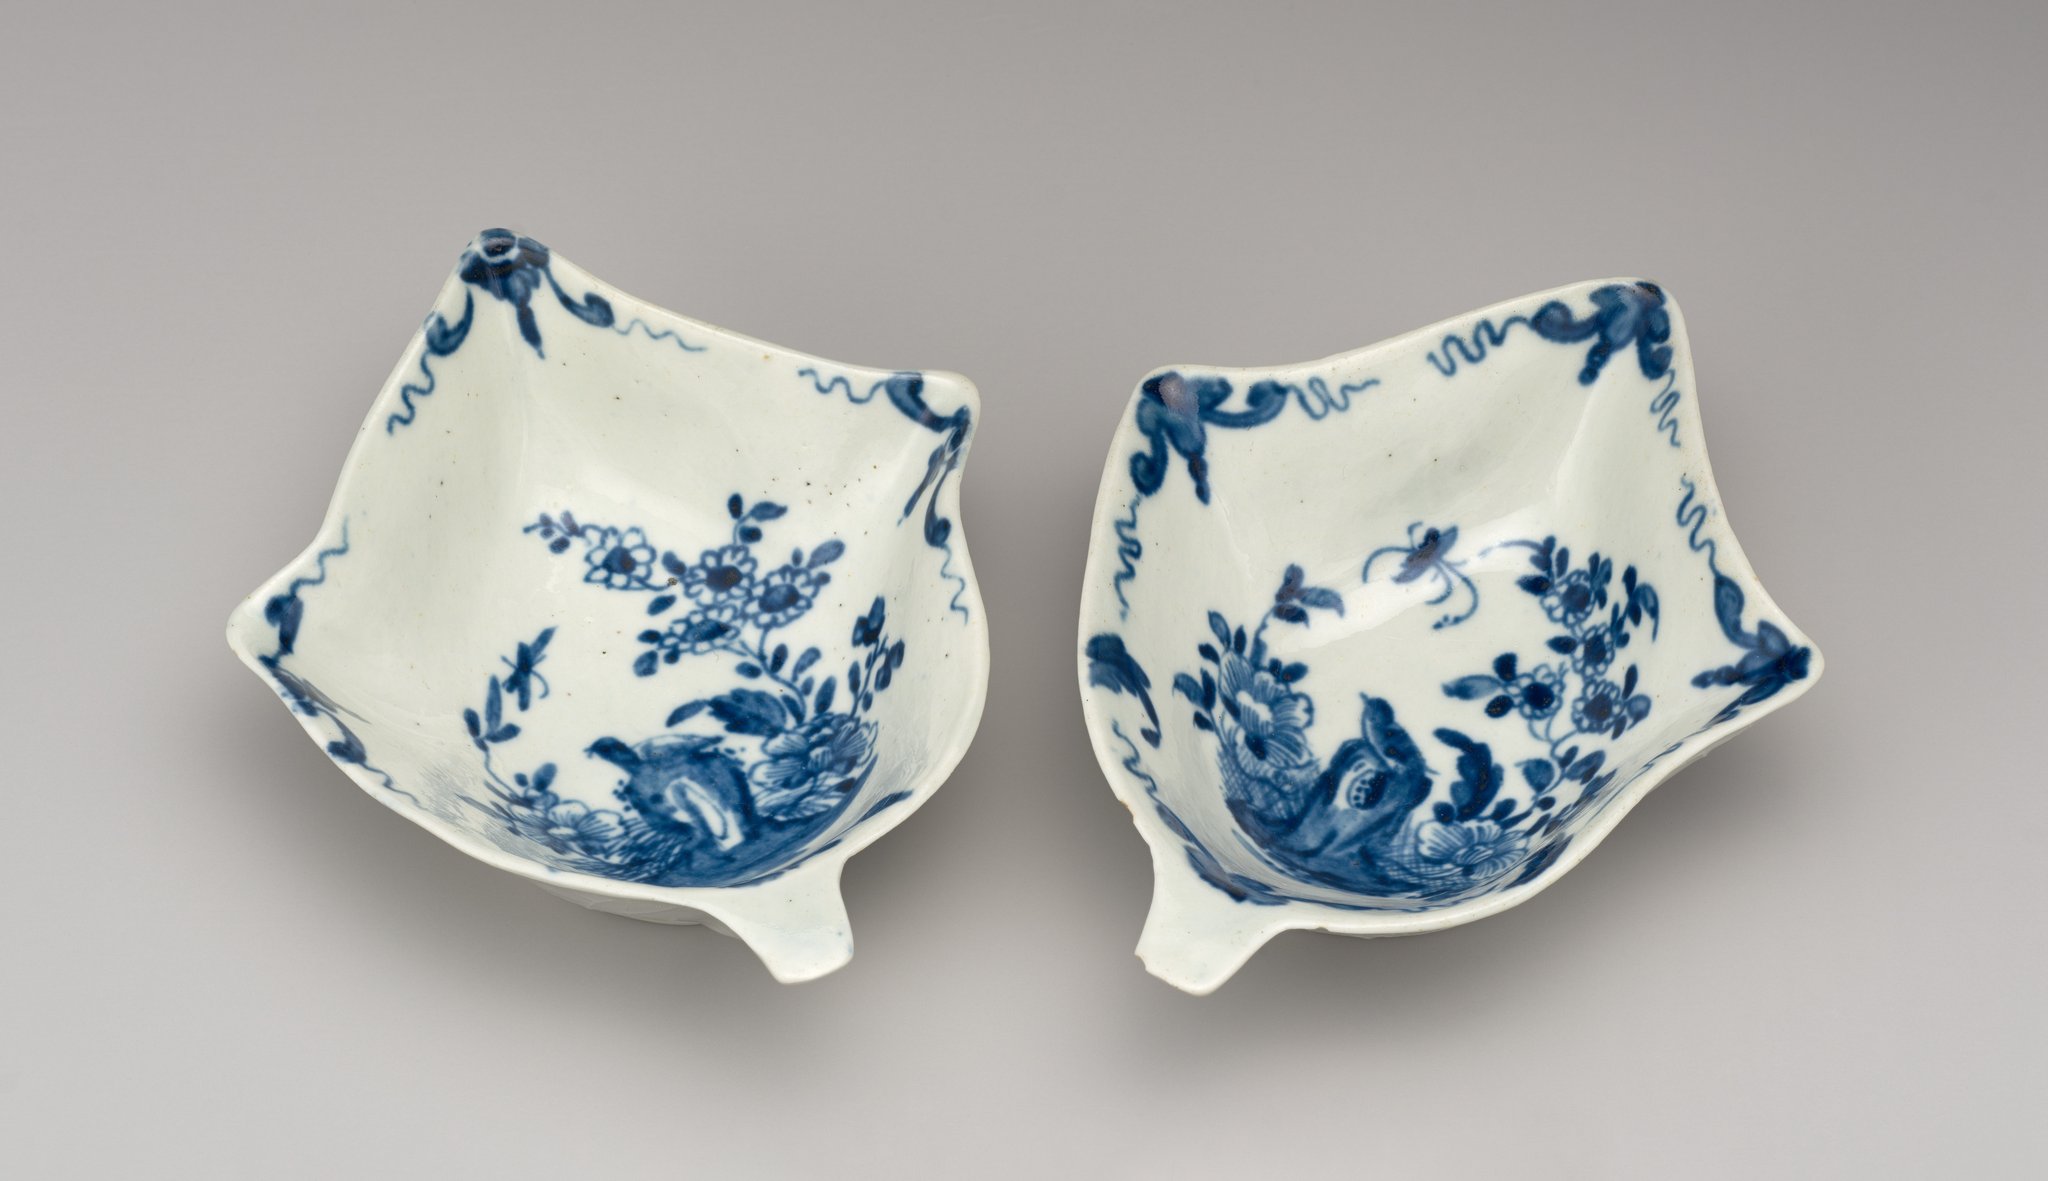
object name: dish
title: Pair of dishes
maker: worcester factory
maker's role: factory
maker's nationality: british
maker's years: 1751-2008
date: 1755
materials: soft paste porcelain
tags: birds